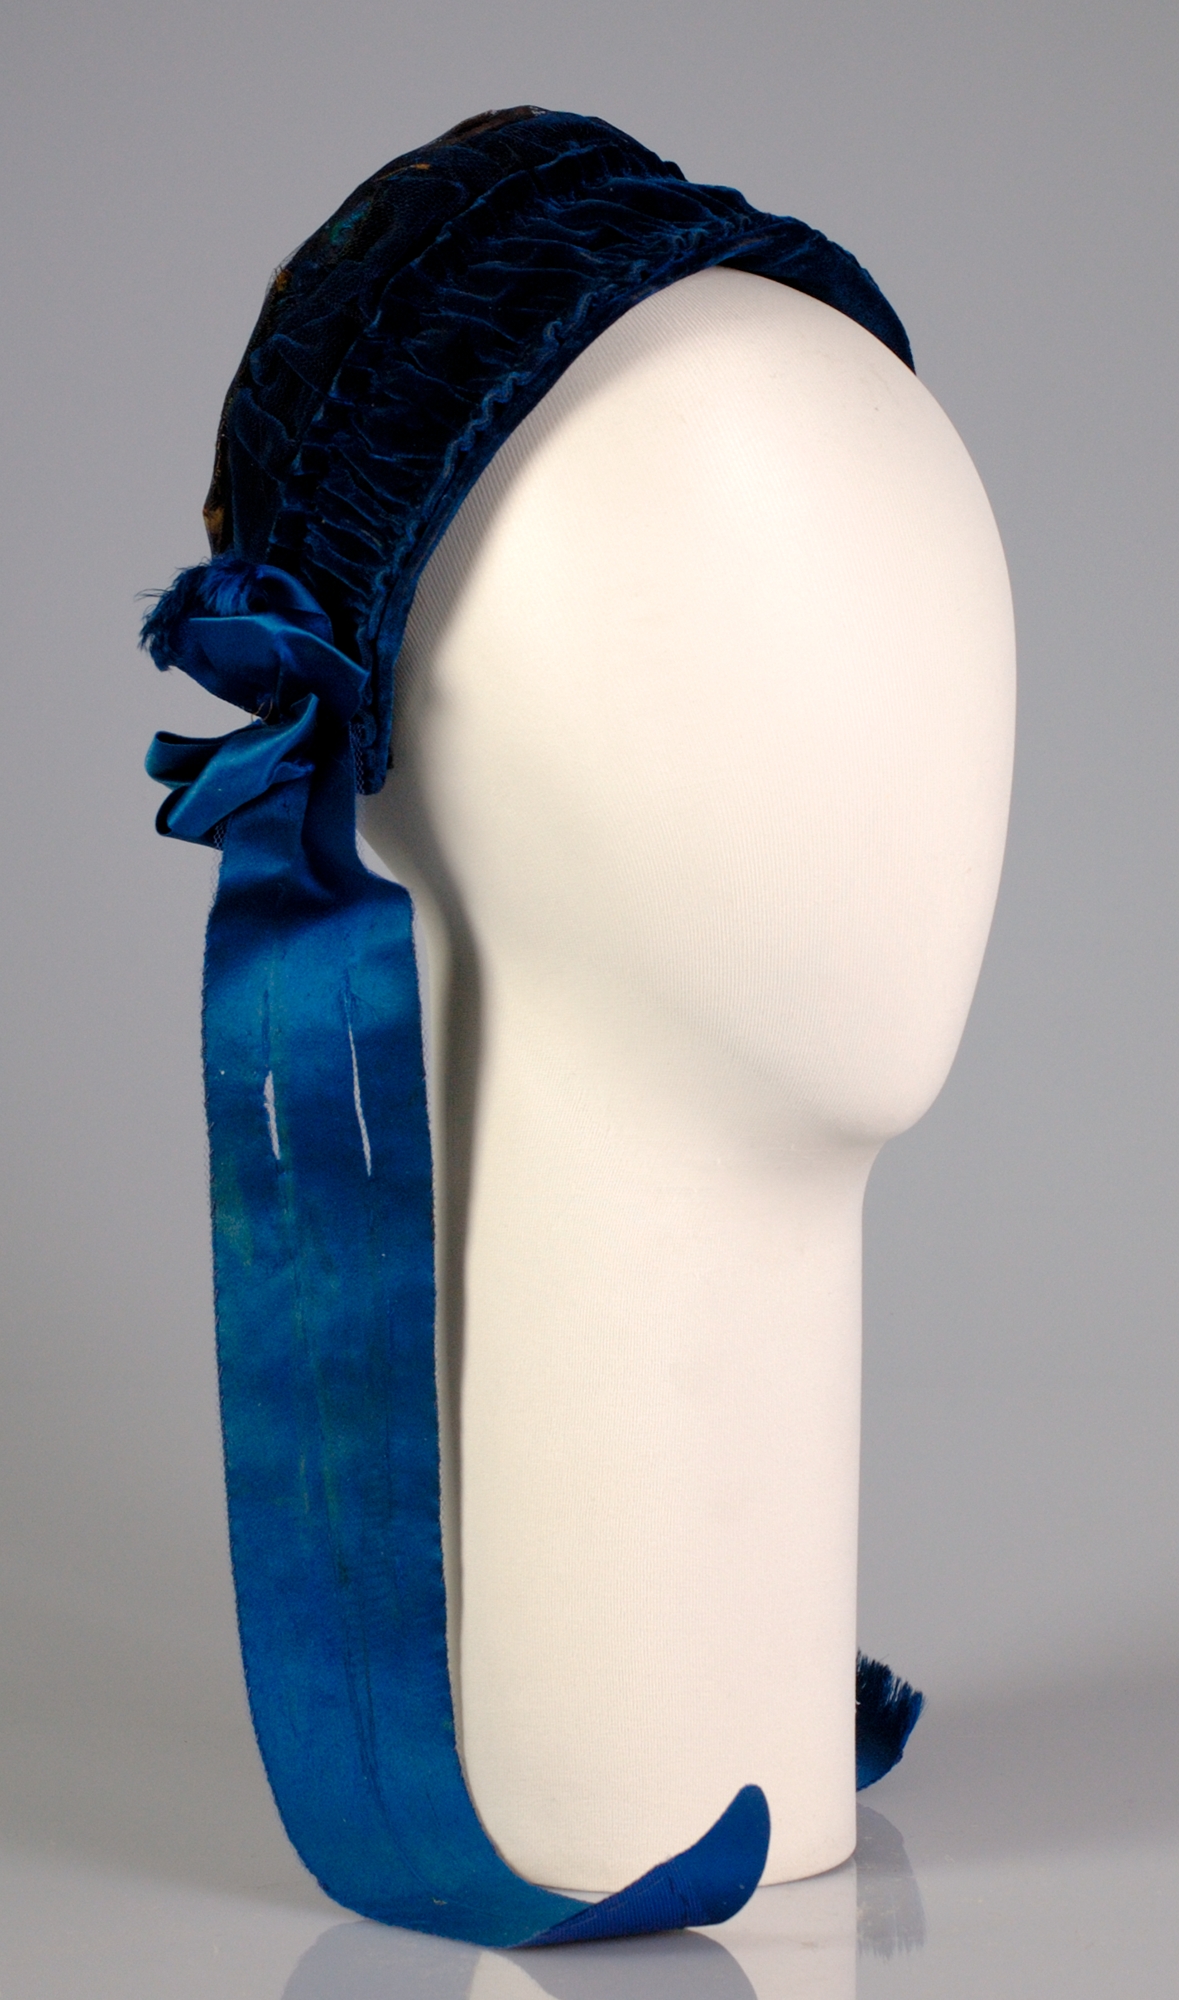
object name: evening bonnet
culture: american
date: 1880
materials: feather, silk